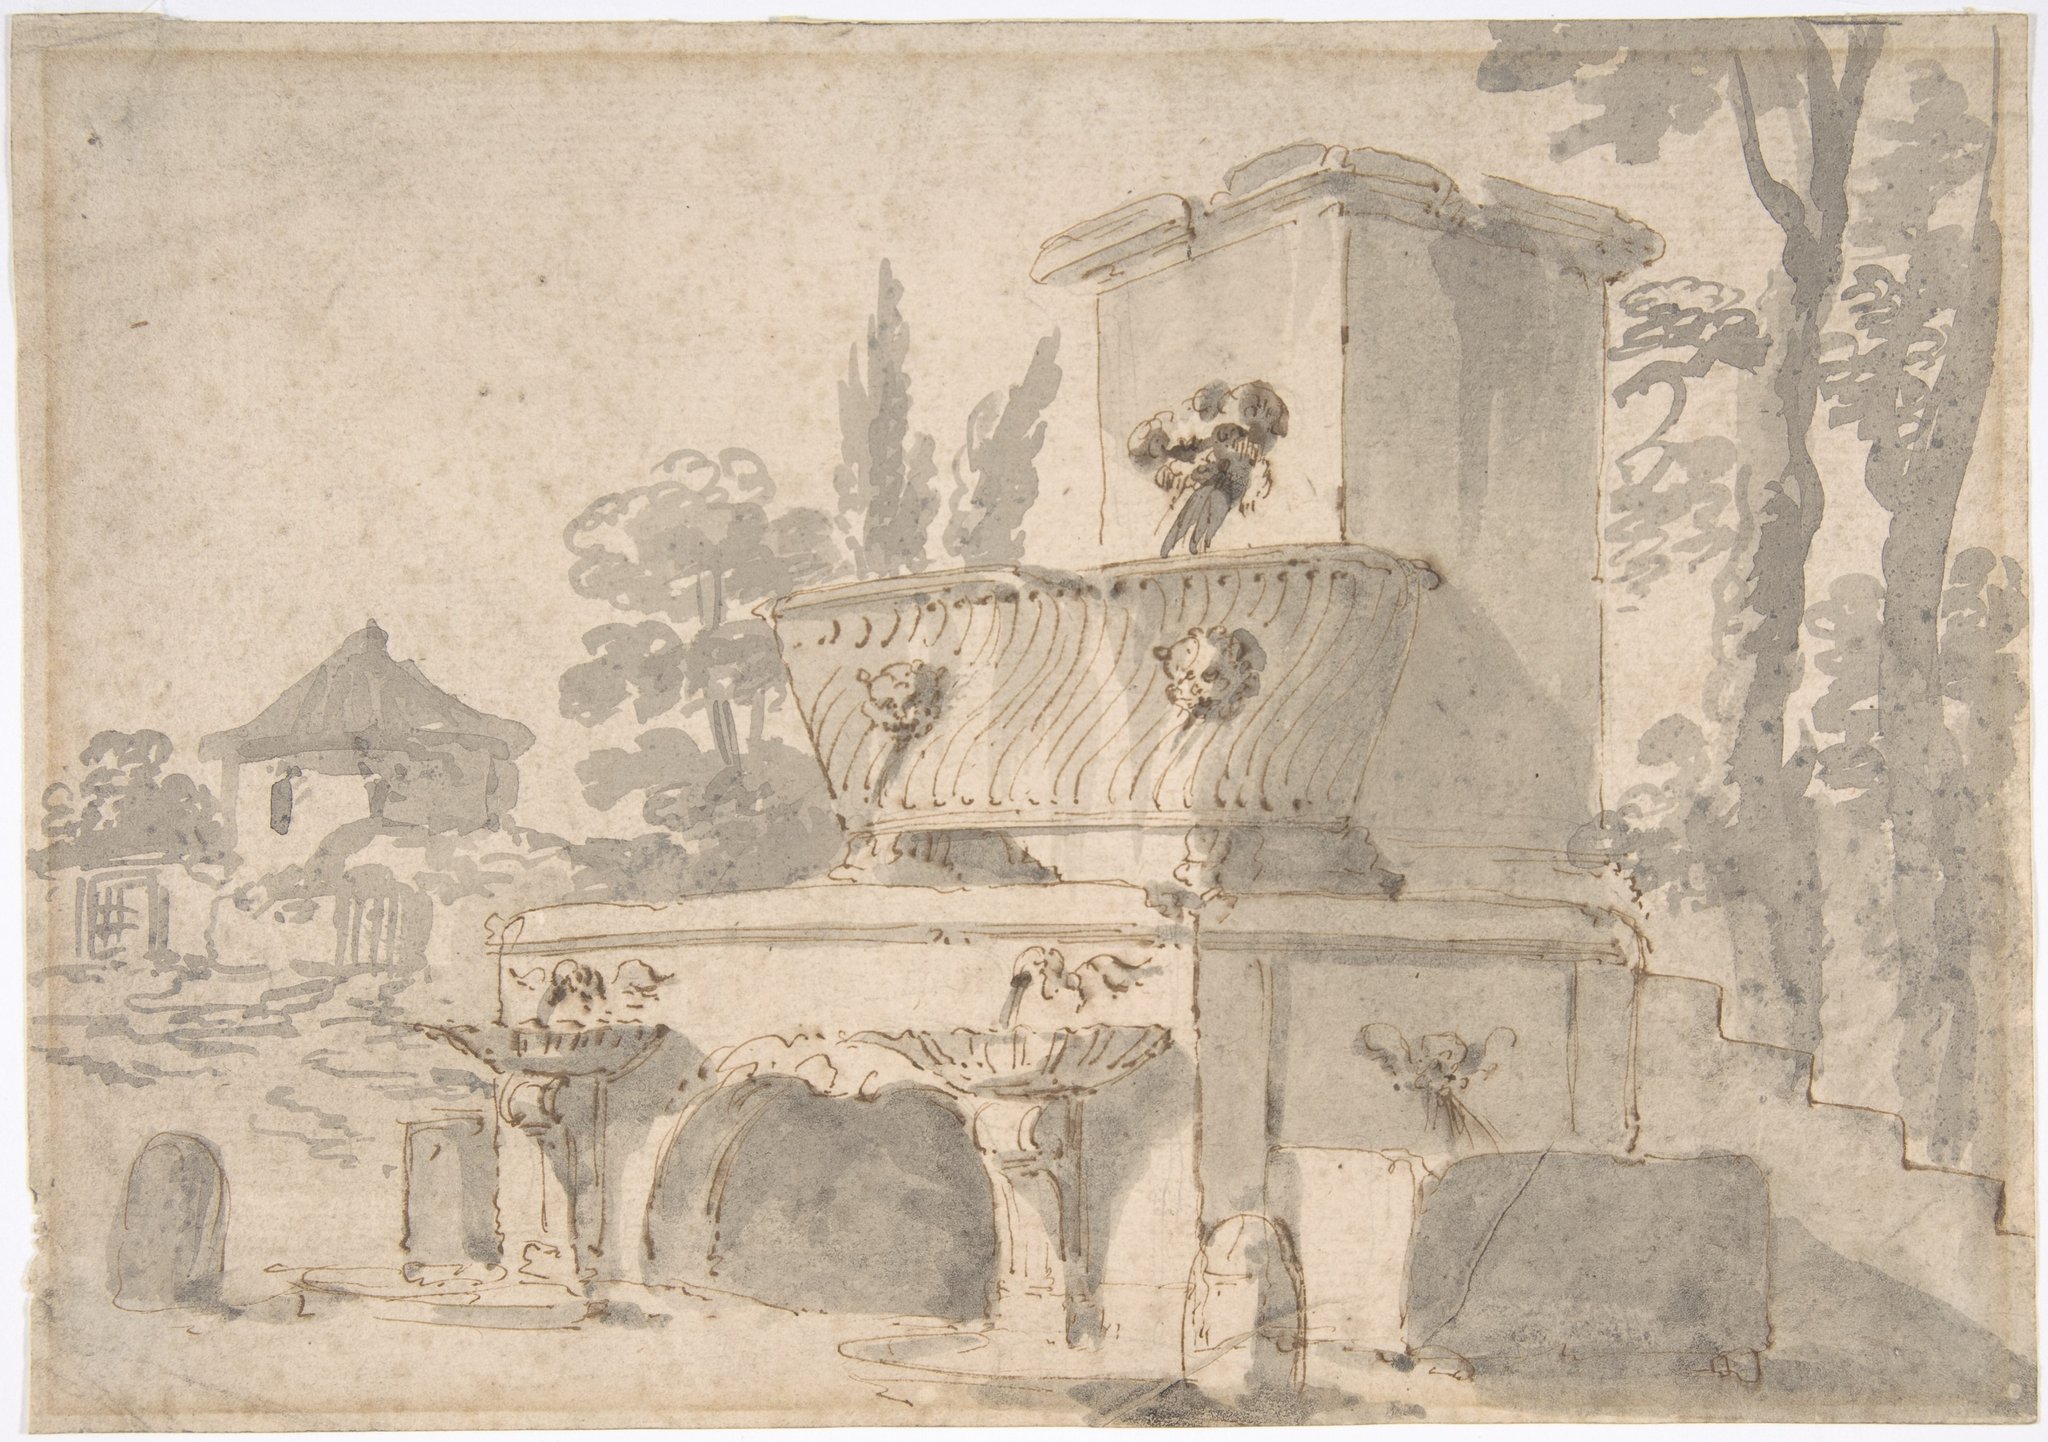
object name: drawing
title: Venetian Capriccio: Landscape with a Farm Building, Sarcophagus, and Fountain (recto); Monument (verso)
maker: giuseppe bernardino bison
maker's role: artist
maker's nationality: italian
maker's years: 1762-1844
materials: chalk, graphite, ink, drawing material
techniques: brush, pen, wash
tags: fountains,farms,sarcophagus